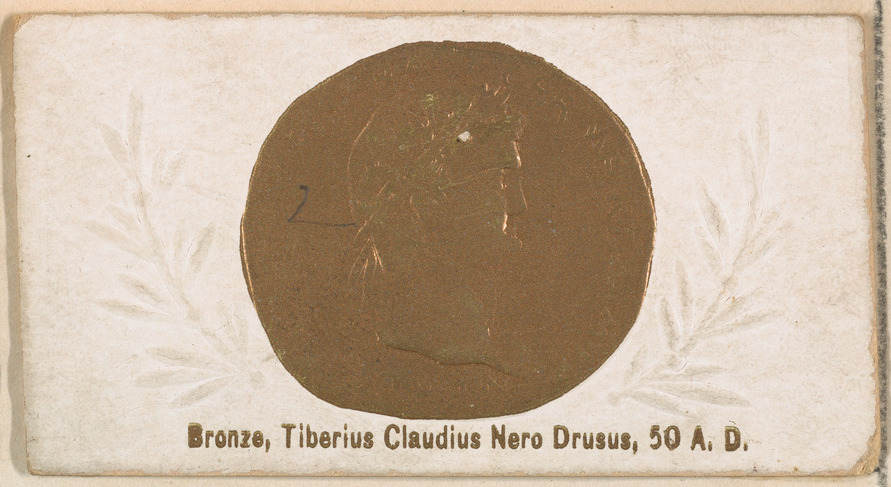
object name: print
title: Bronze, Tiberius Claudius Nero Drusus, 50 A.D., from the Ancient Coins series (N180) issued by Wm. S. Kimball & Co.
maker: william s. kimball & company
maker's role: publisher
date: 1888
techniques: color lithograph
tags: men,coins